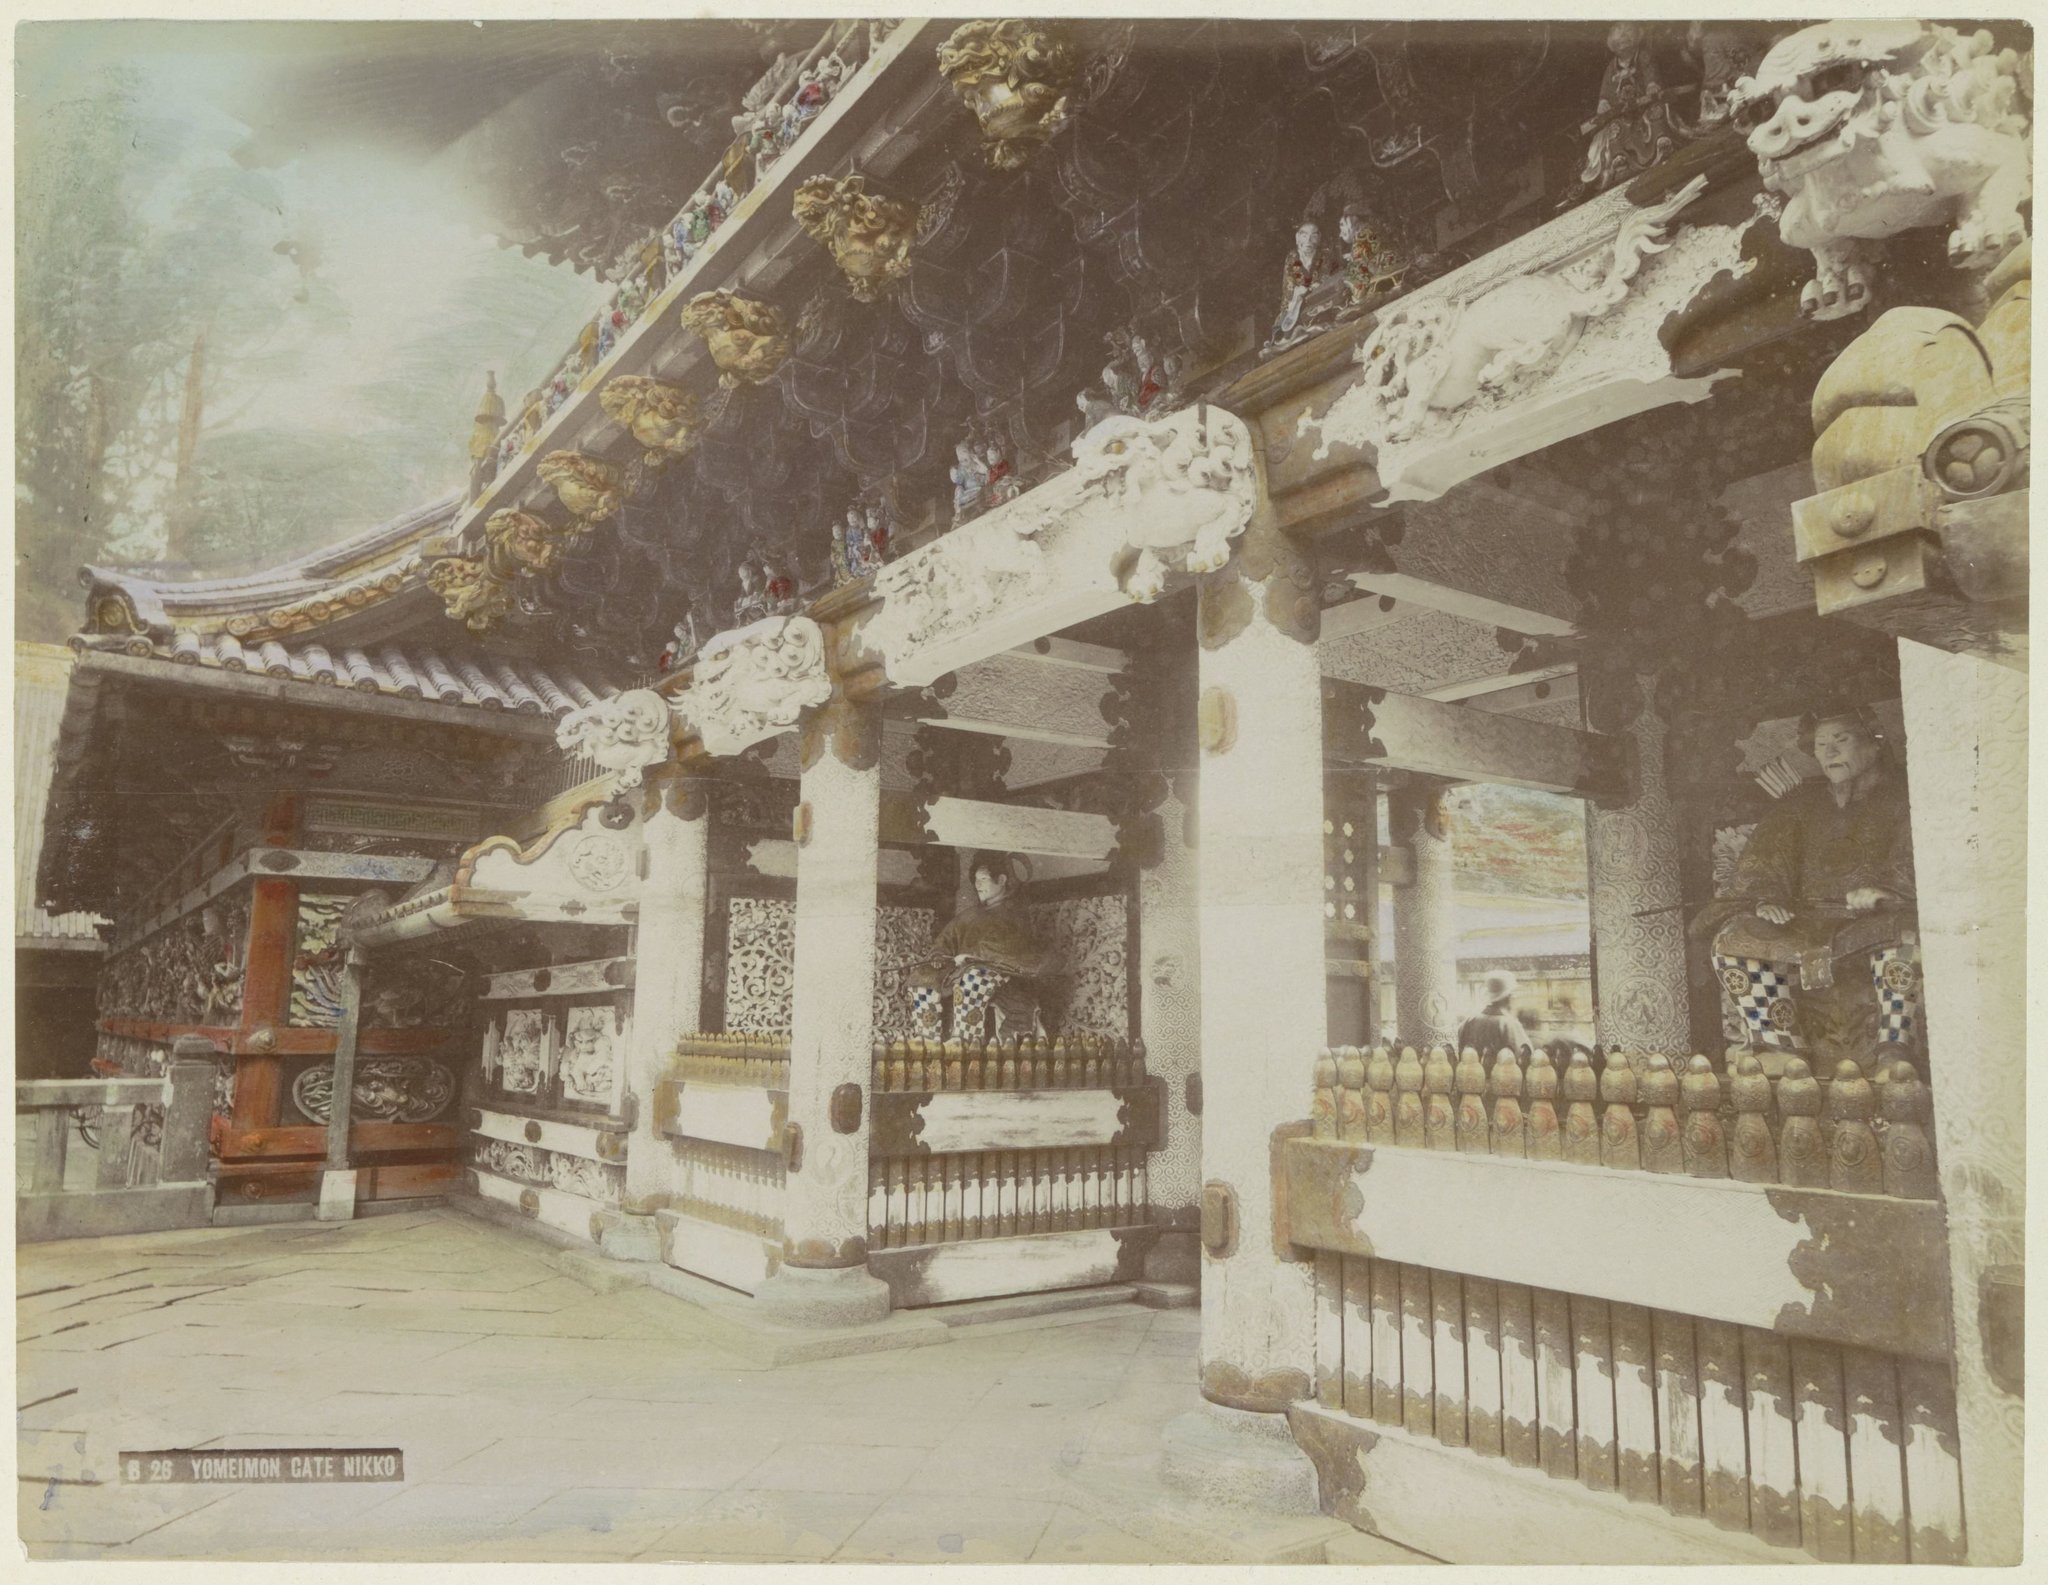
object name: photograph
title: Yomeimon Gate Nikko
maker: Anonymous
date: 1870-1900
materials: cardboard, paper, photographic support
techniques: albumen print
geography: nikko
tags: temple, shrine ~ hinduism, buddhism, jainism, gate, entrance, piece of sculpture, reproduction of a piece of sculpture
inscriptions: negative number: ‘B26’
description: Onderdeel van Reisalbum met foto's van bezienswaardigheden in Japan.